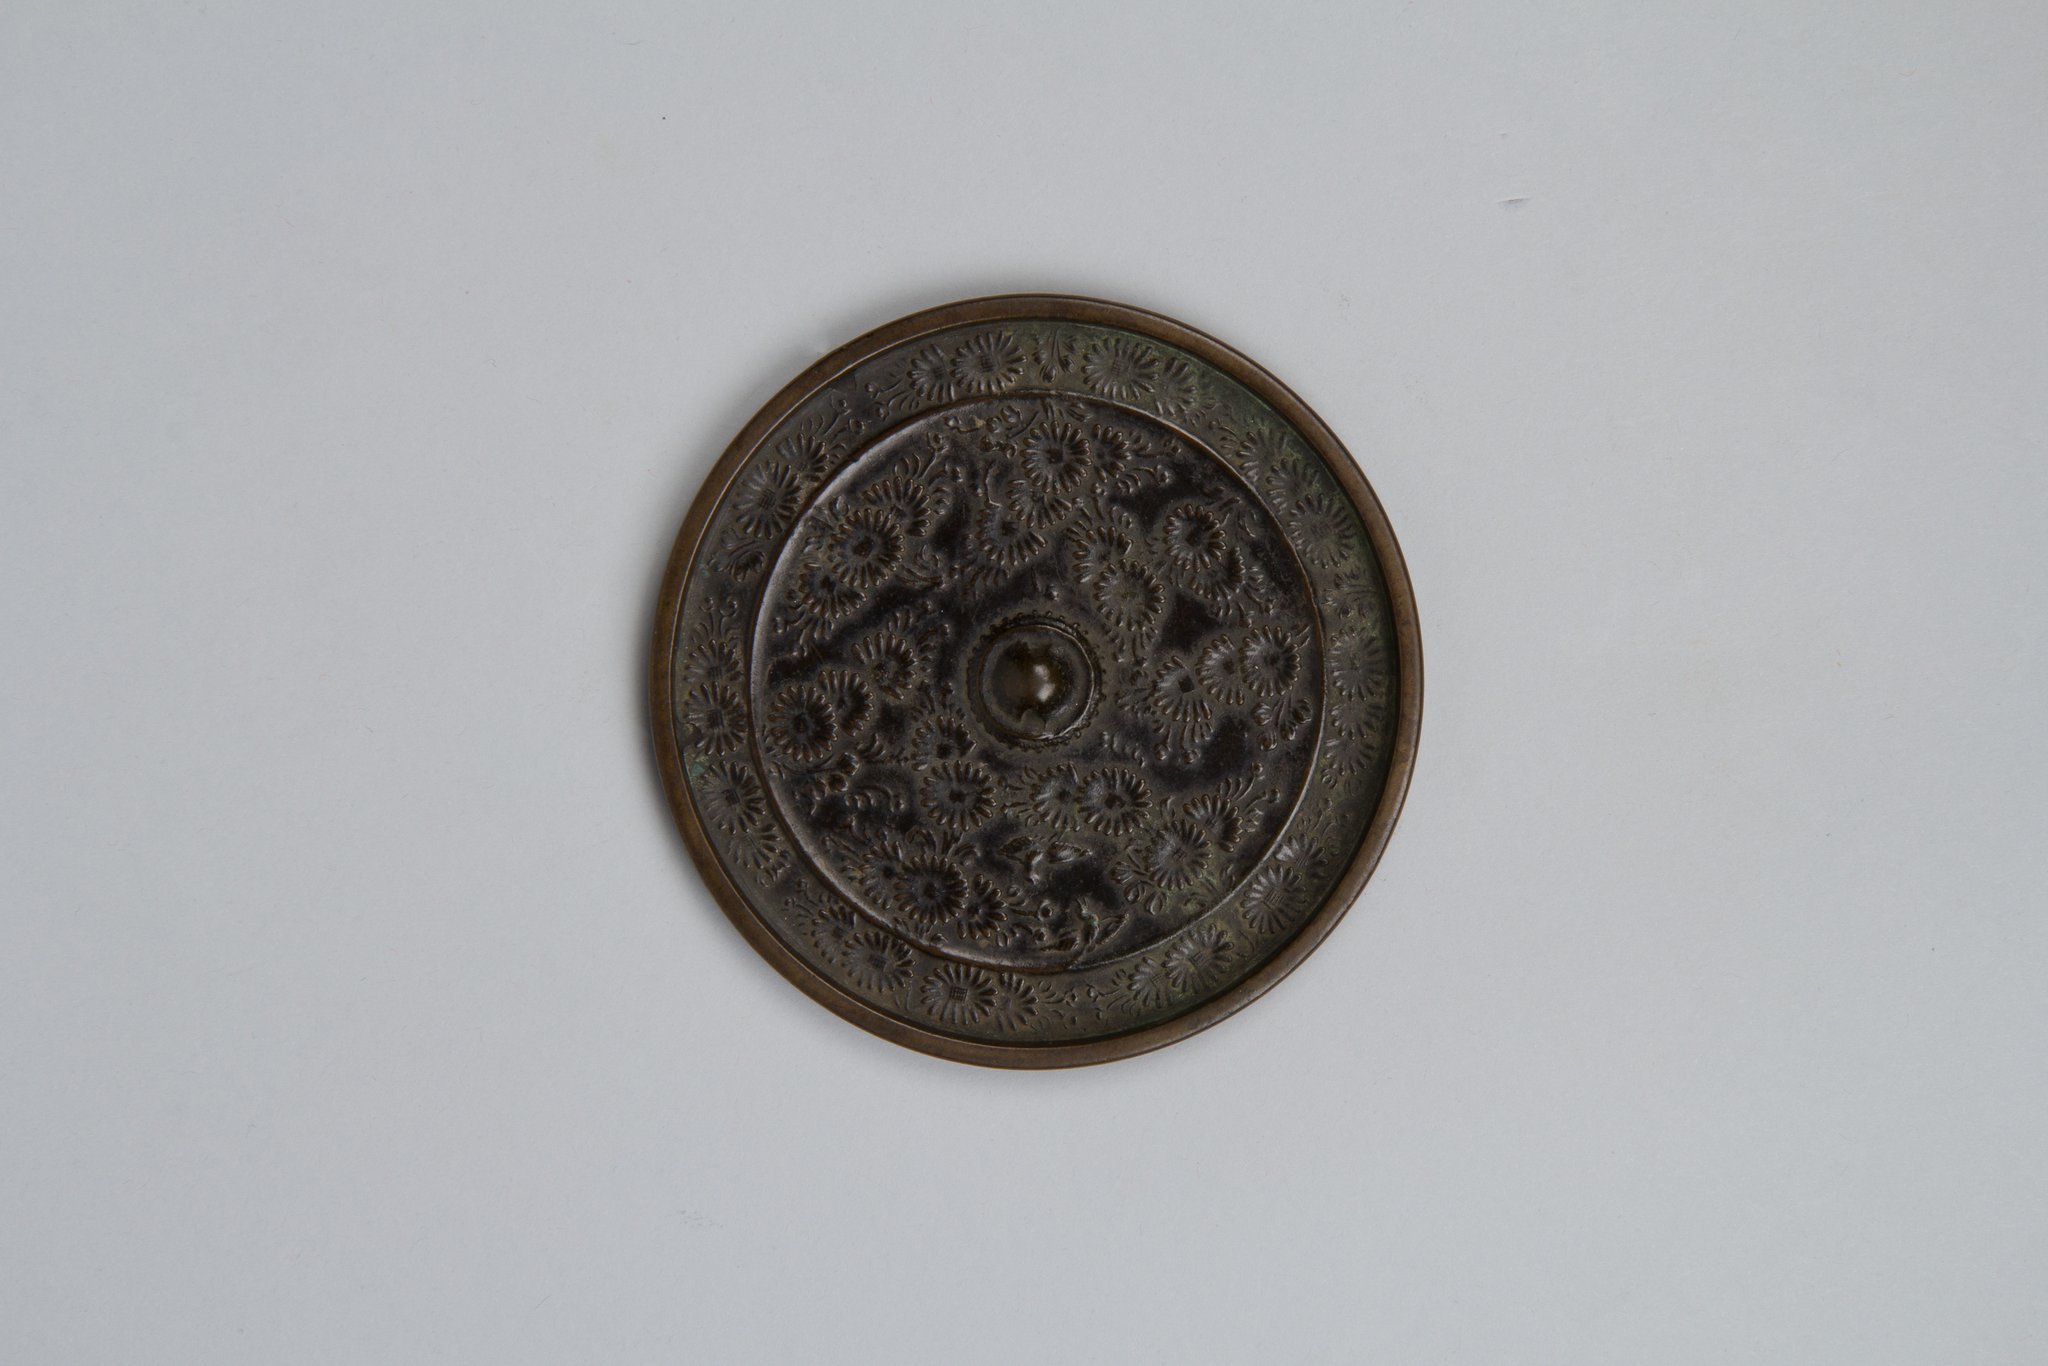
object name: mirror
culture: japanese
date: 1185-1333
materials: bronze